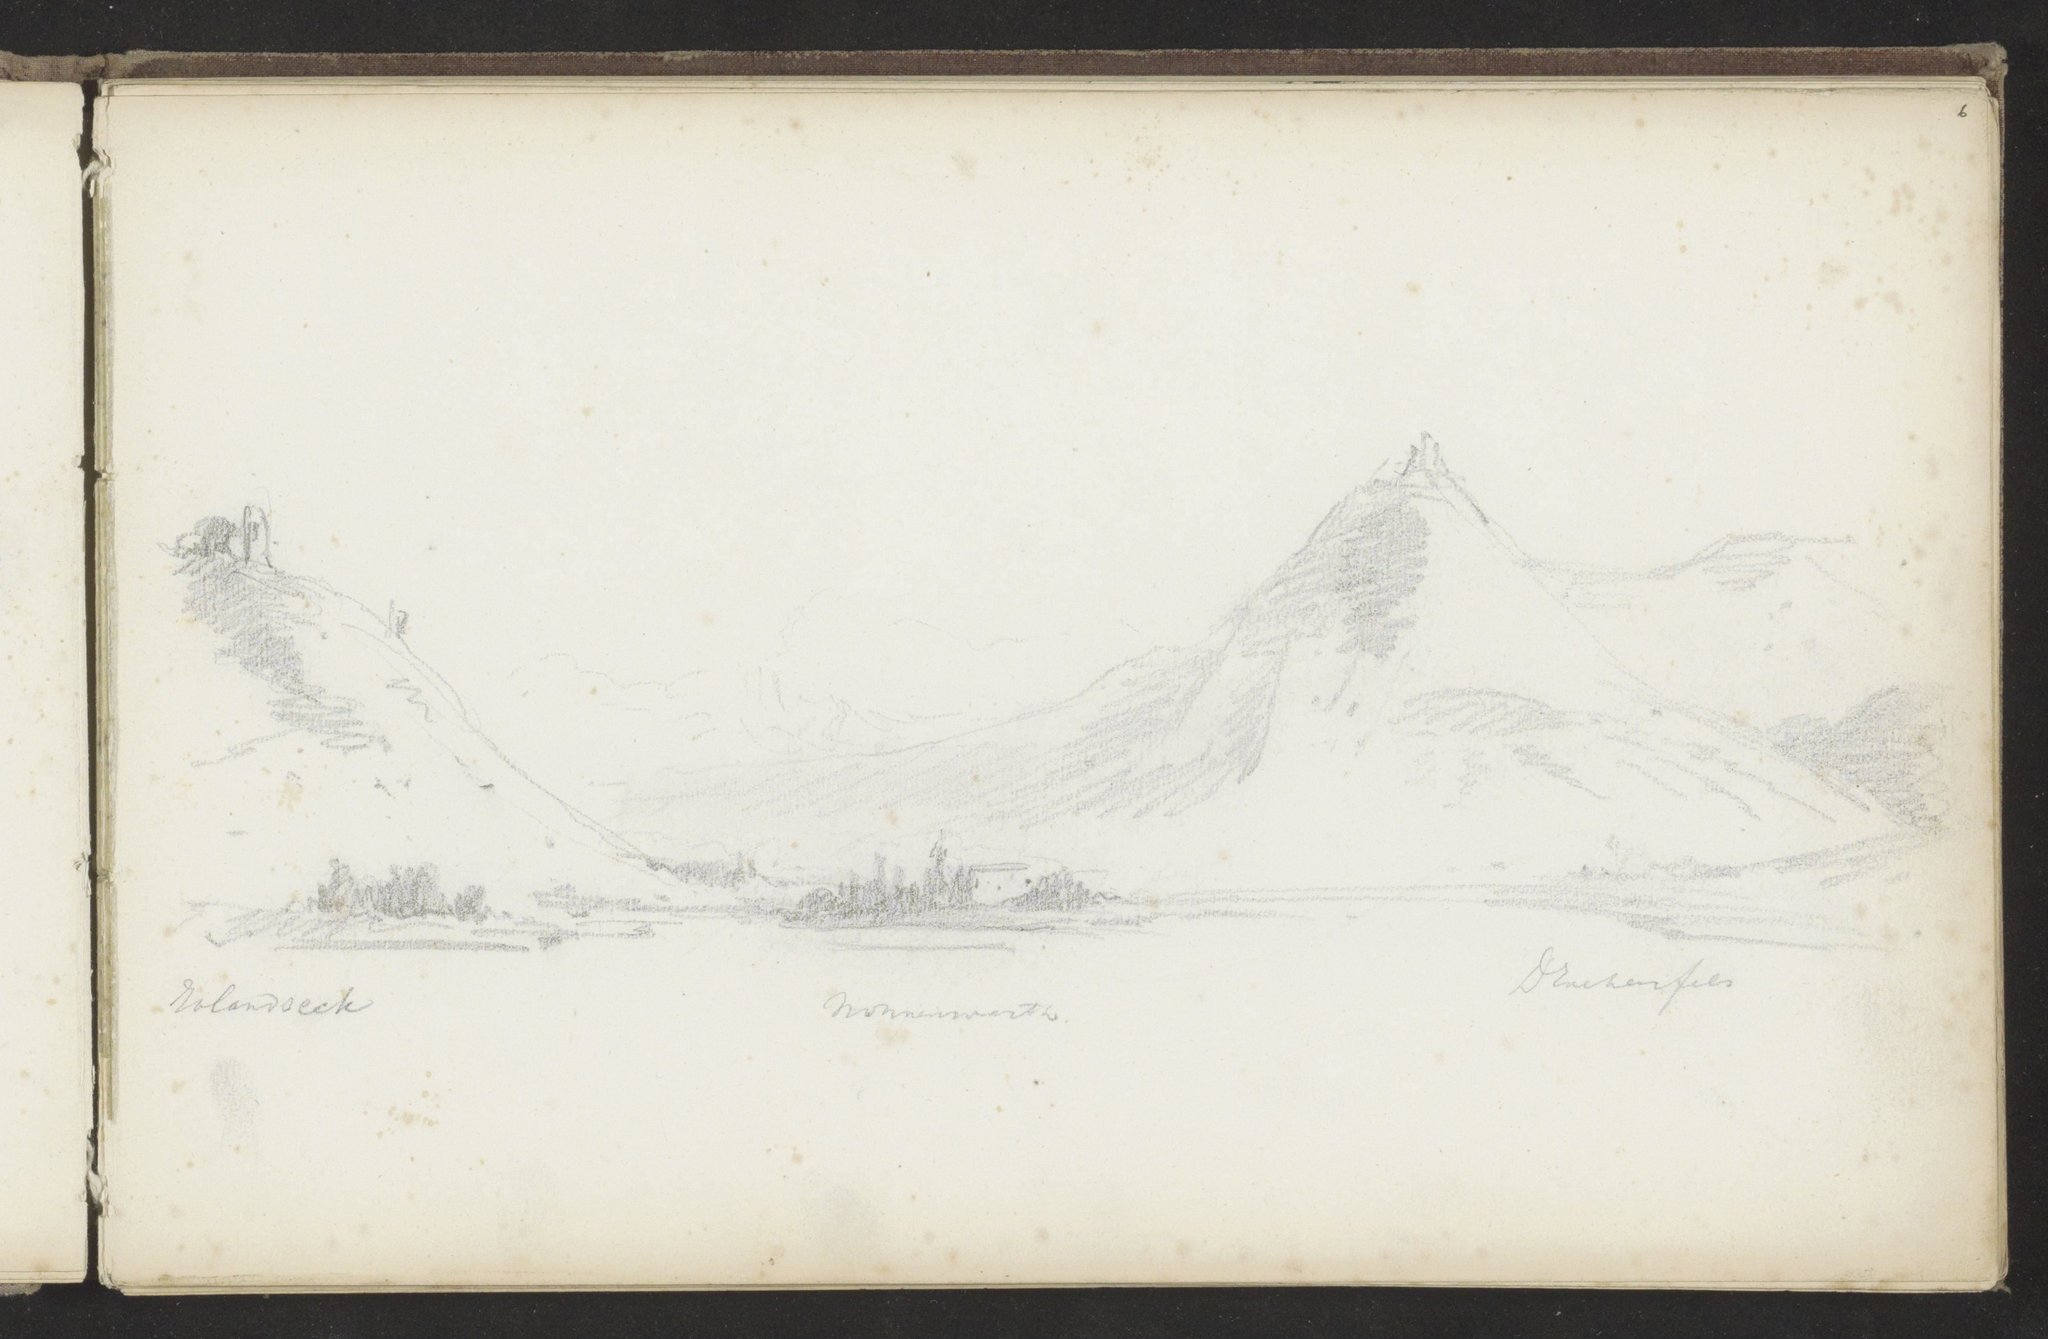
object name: sketchbook leaf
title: Gezicht op Rolandseck, het eiland Nonnenwerth en Drachenfels aan de Rijn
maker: maria vos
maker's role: draughtsman, painter, print maker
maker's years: 1824-1906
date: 1860-1865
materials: paper, pencil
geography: nonnenwerth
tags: city-view, and landscape with man-made constructions, landscapes with waters, waterscapes, seascapes (in the temperate zone), mountains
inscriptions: annotation: ‘rolandseck nonnenwerth Drachenfels’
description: Blad 6 recto uit een schetsboek met 55 bladen.